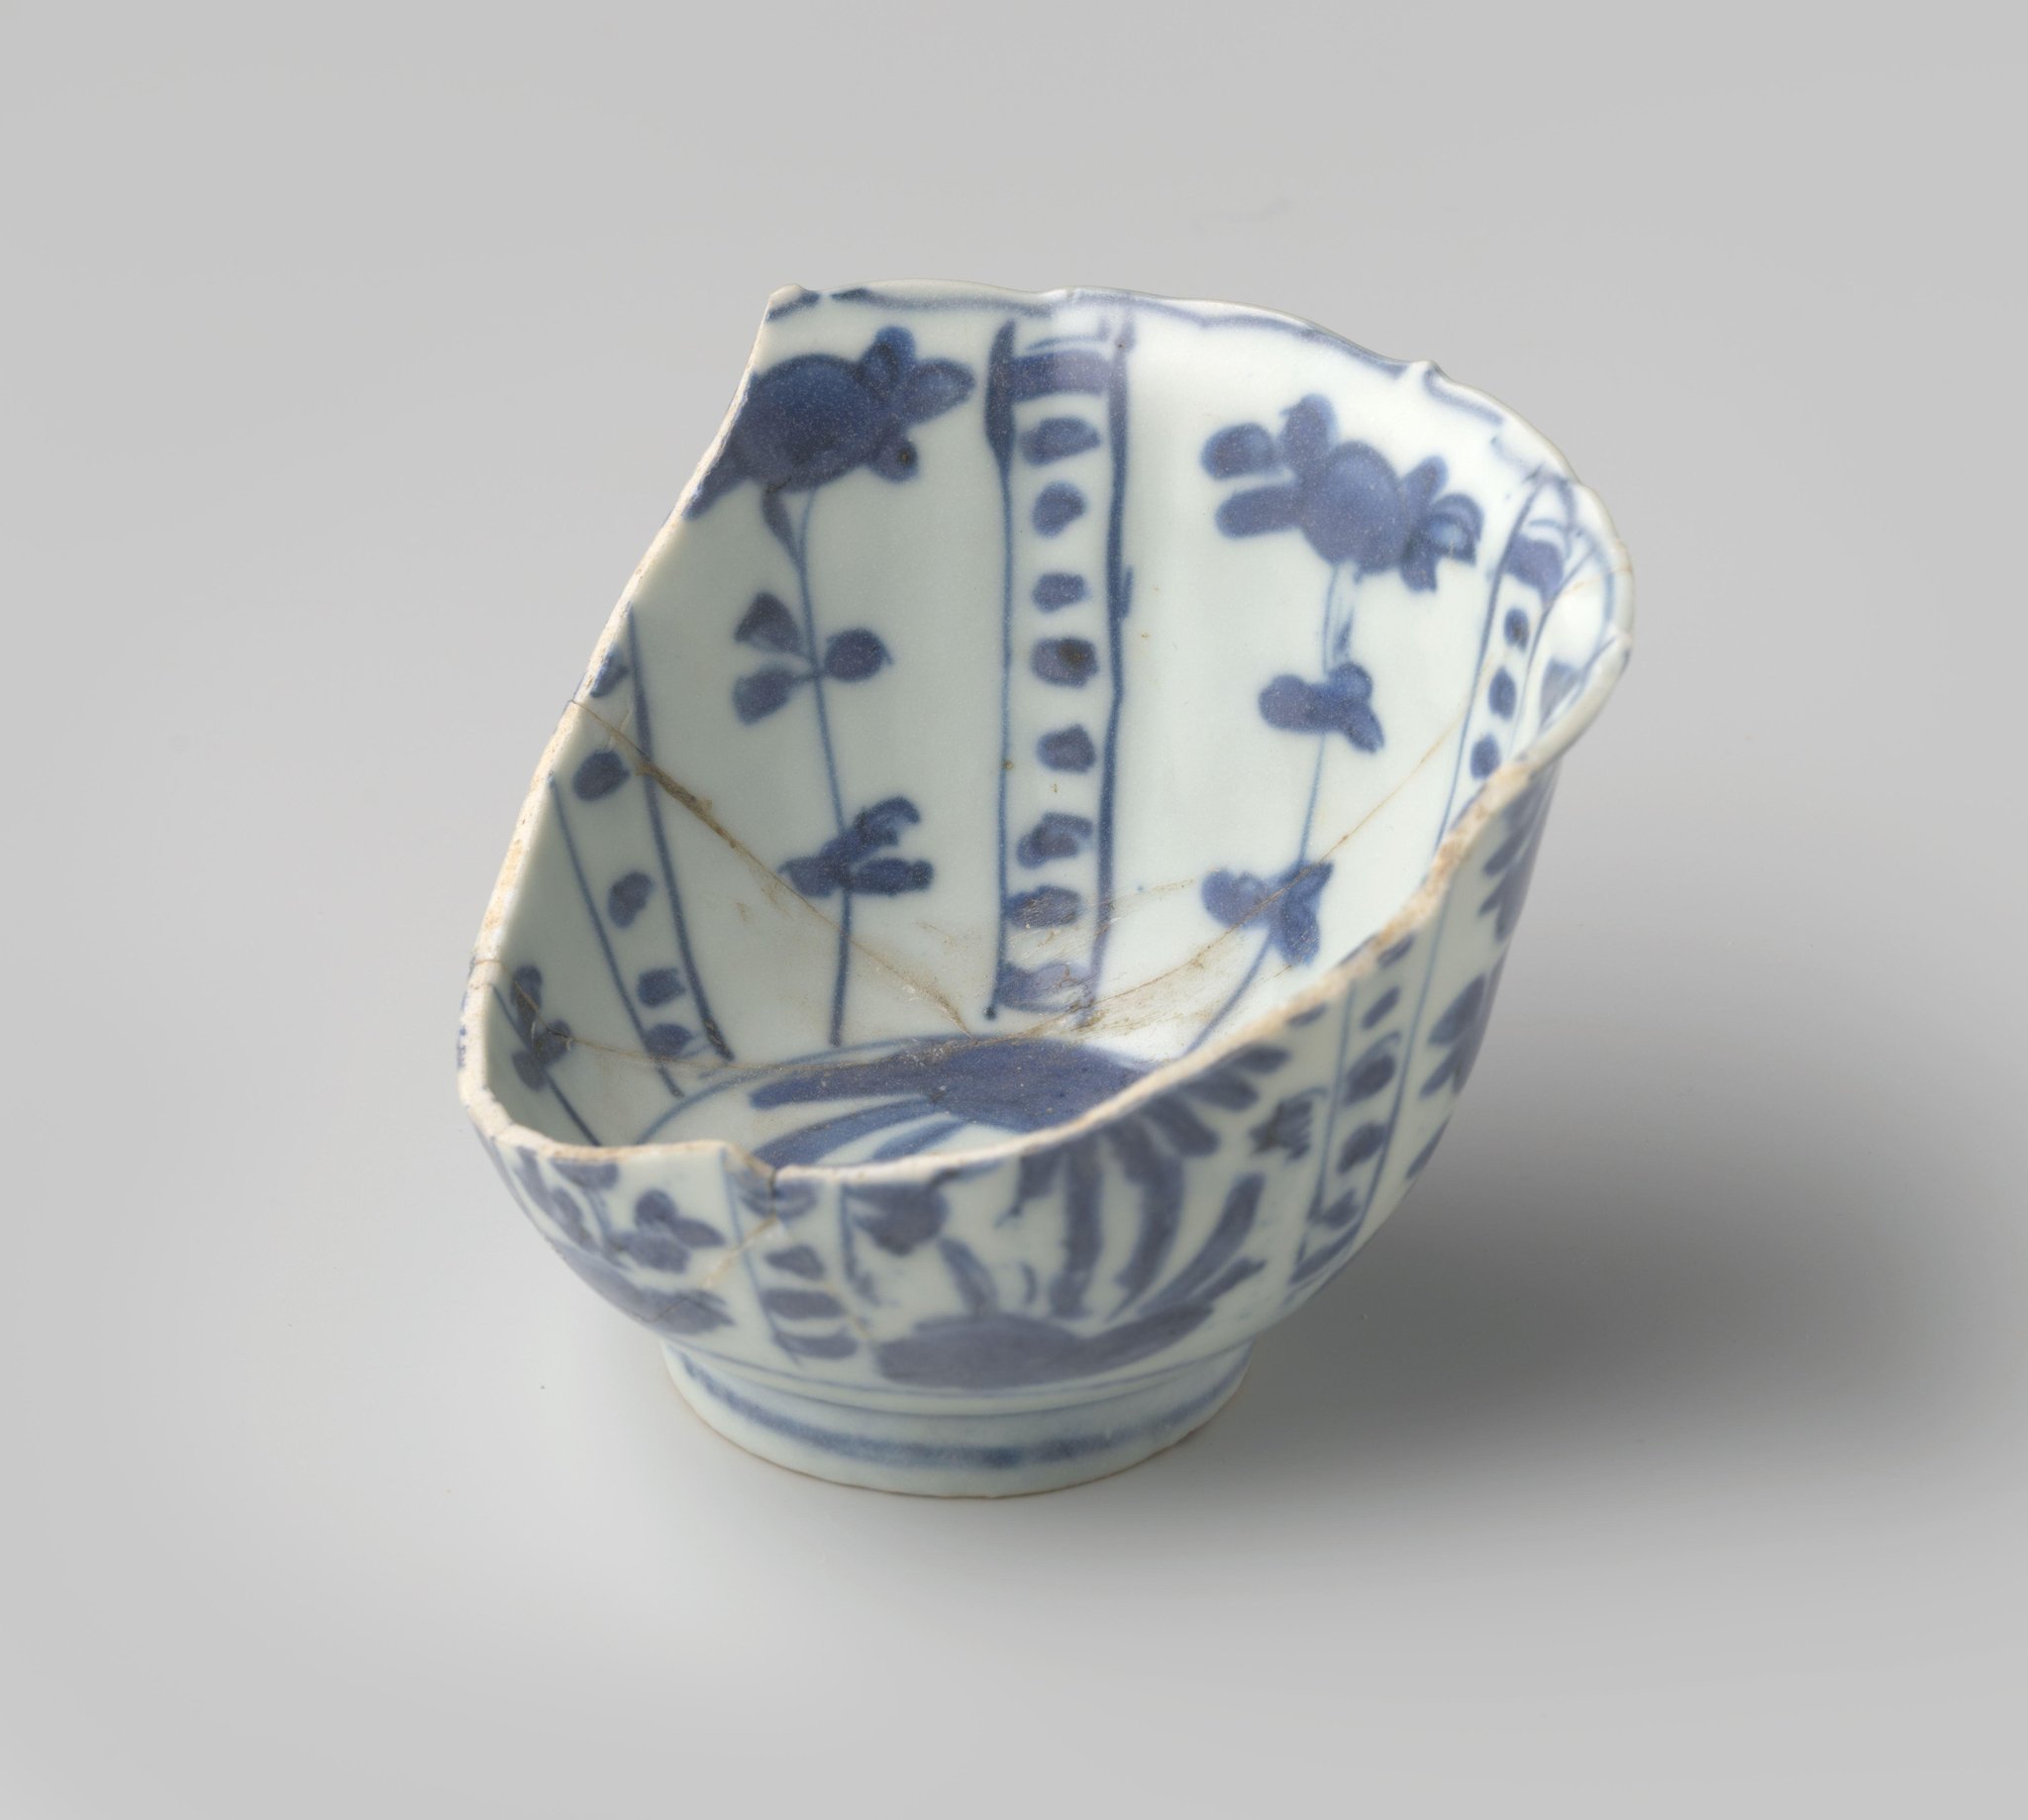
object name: bowl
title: Kom uit V.O.C.-schip de 'Witte Leeuw'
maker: Anonymous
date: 1613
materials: bone china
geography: jingdezhen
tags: verenigde oostindische compagnie, sint-helena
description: A high bowl. Th einterior panels are decorated with peach-sprays. The exterior with bamboo and butterflies. The narrow panels have lingzi (fungi). This piece is of a better quality than the other ones of this type.